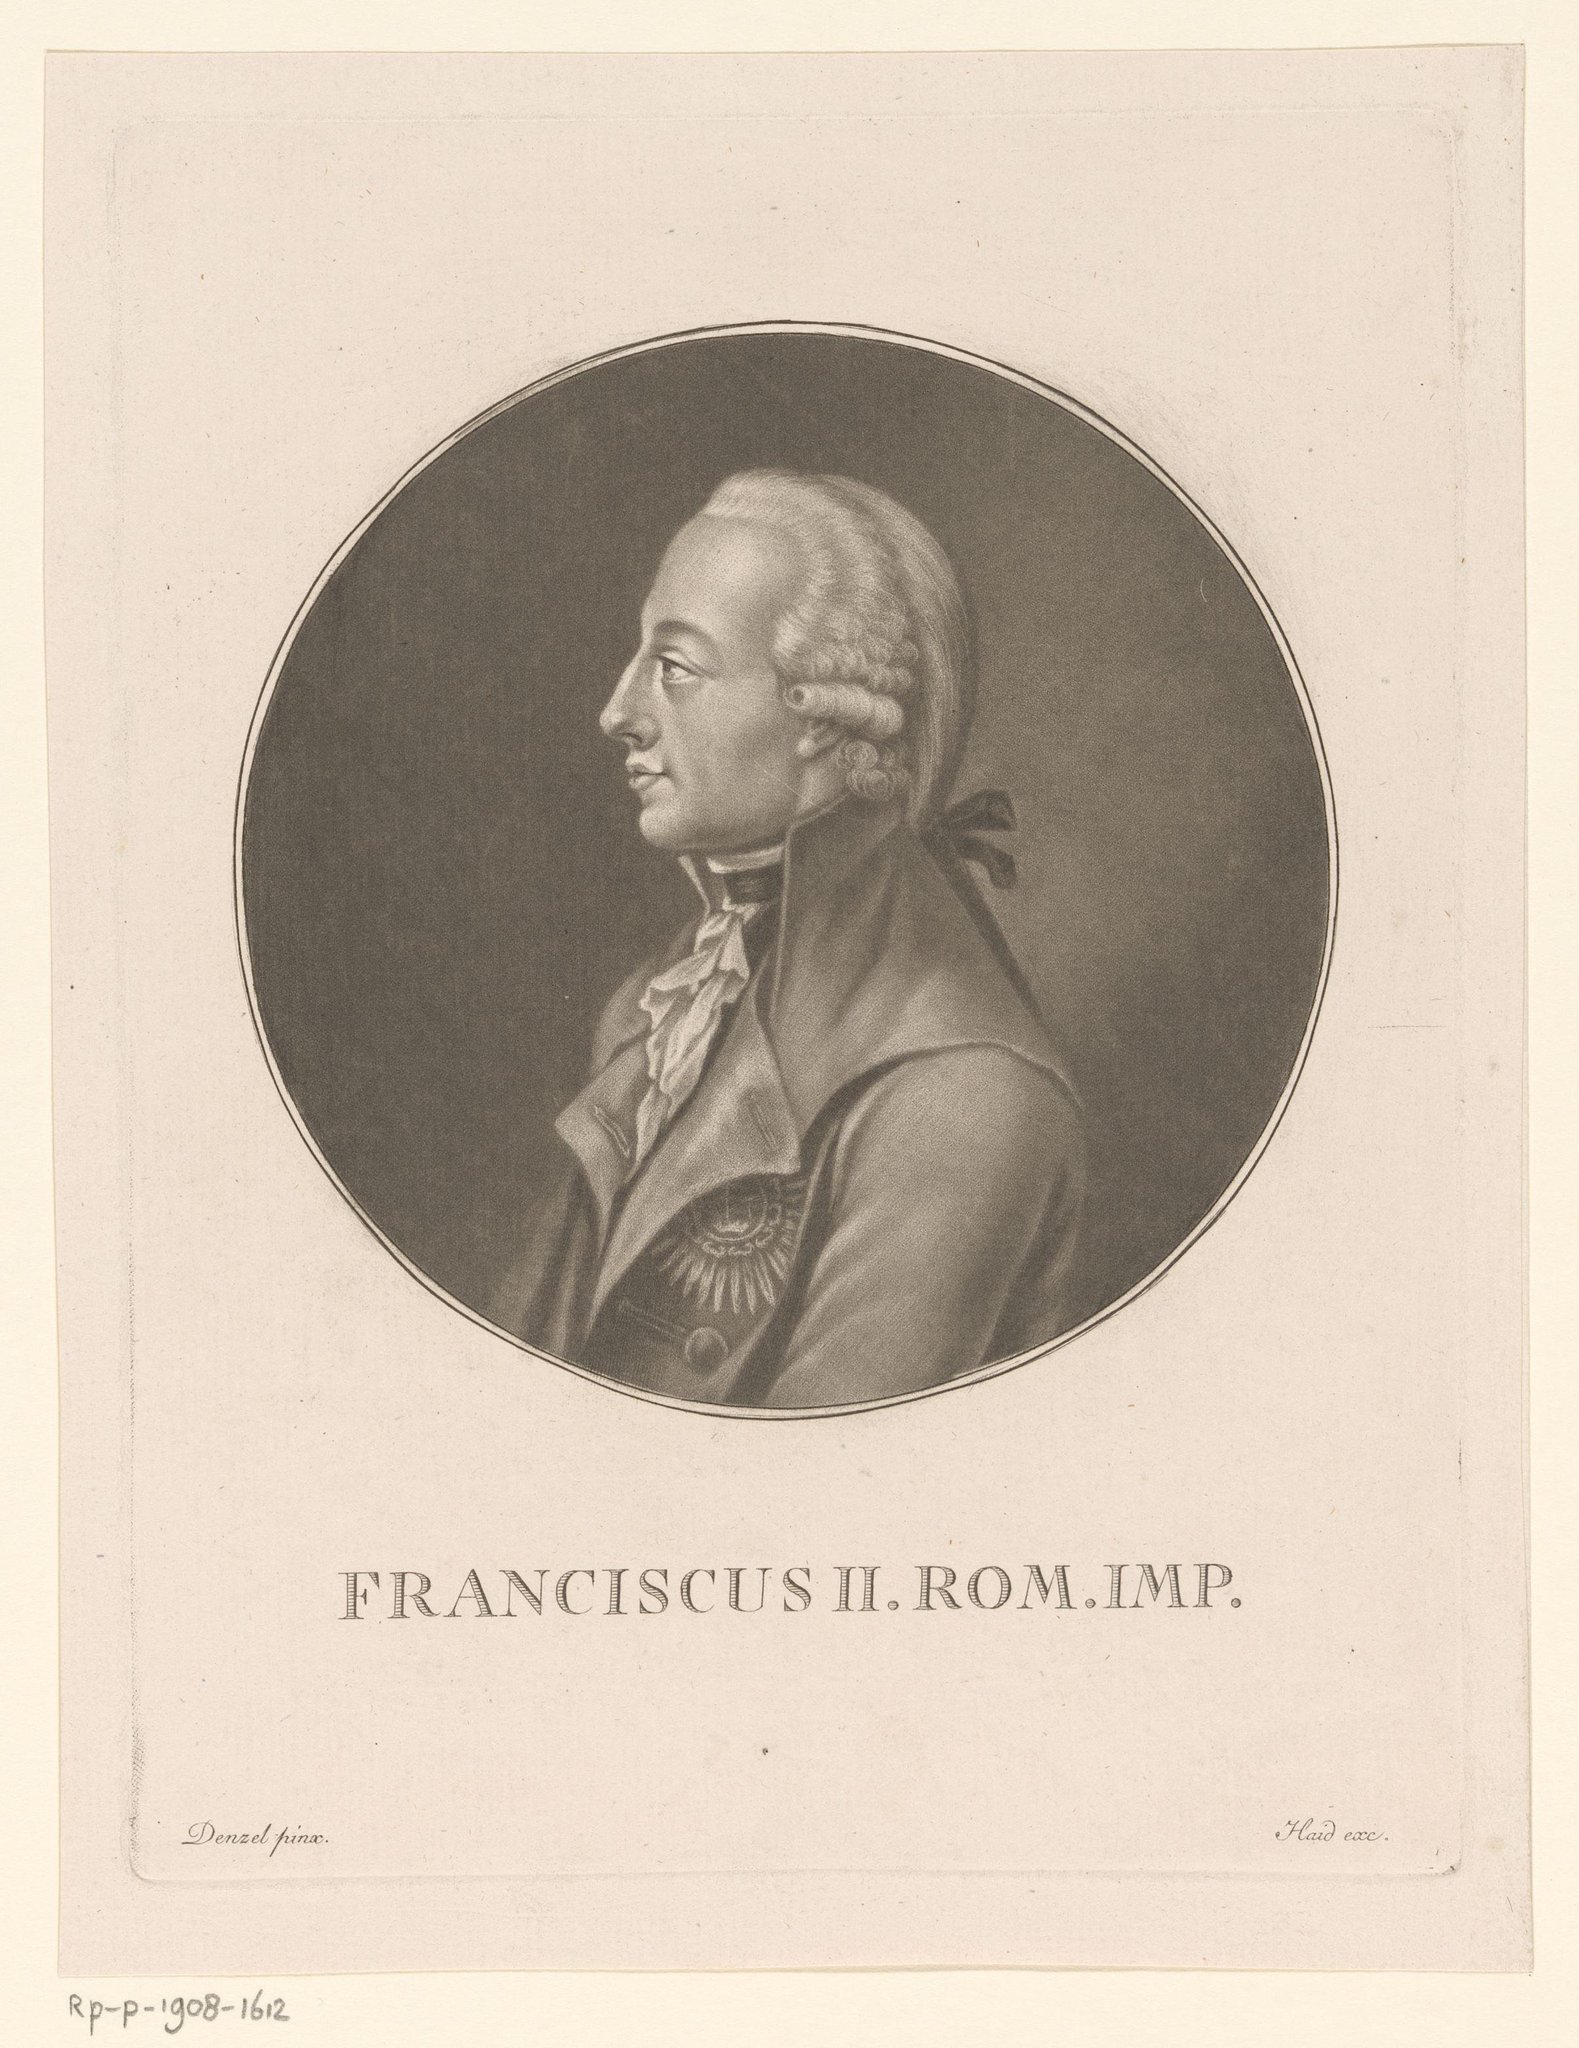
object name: print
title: Portret van Frans II Josef Karel, Rooms-Duits keizer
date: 1778-1809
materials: paper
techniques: mezzotint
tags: vienna, frans ii (rooms-duits keizer), knighthood order, historical persons, emperor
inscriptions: collector's mark: Lugt 2228